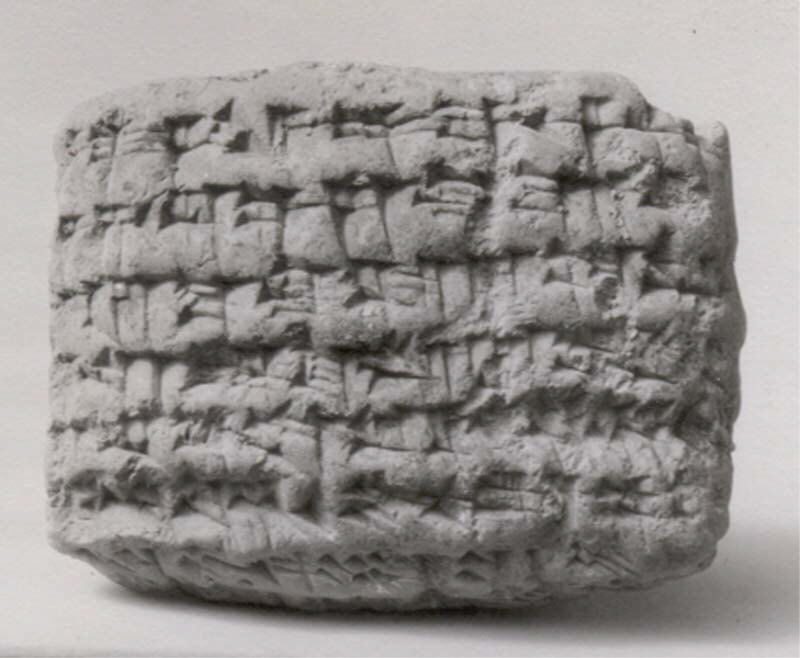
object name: cuneiform tablet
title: Cuneiform tablet: prebend service contract, Esagilaya archive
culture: achaemenid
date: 523 BCE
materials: clay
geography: mesopotamia